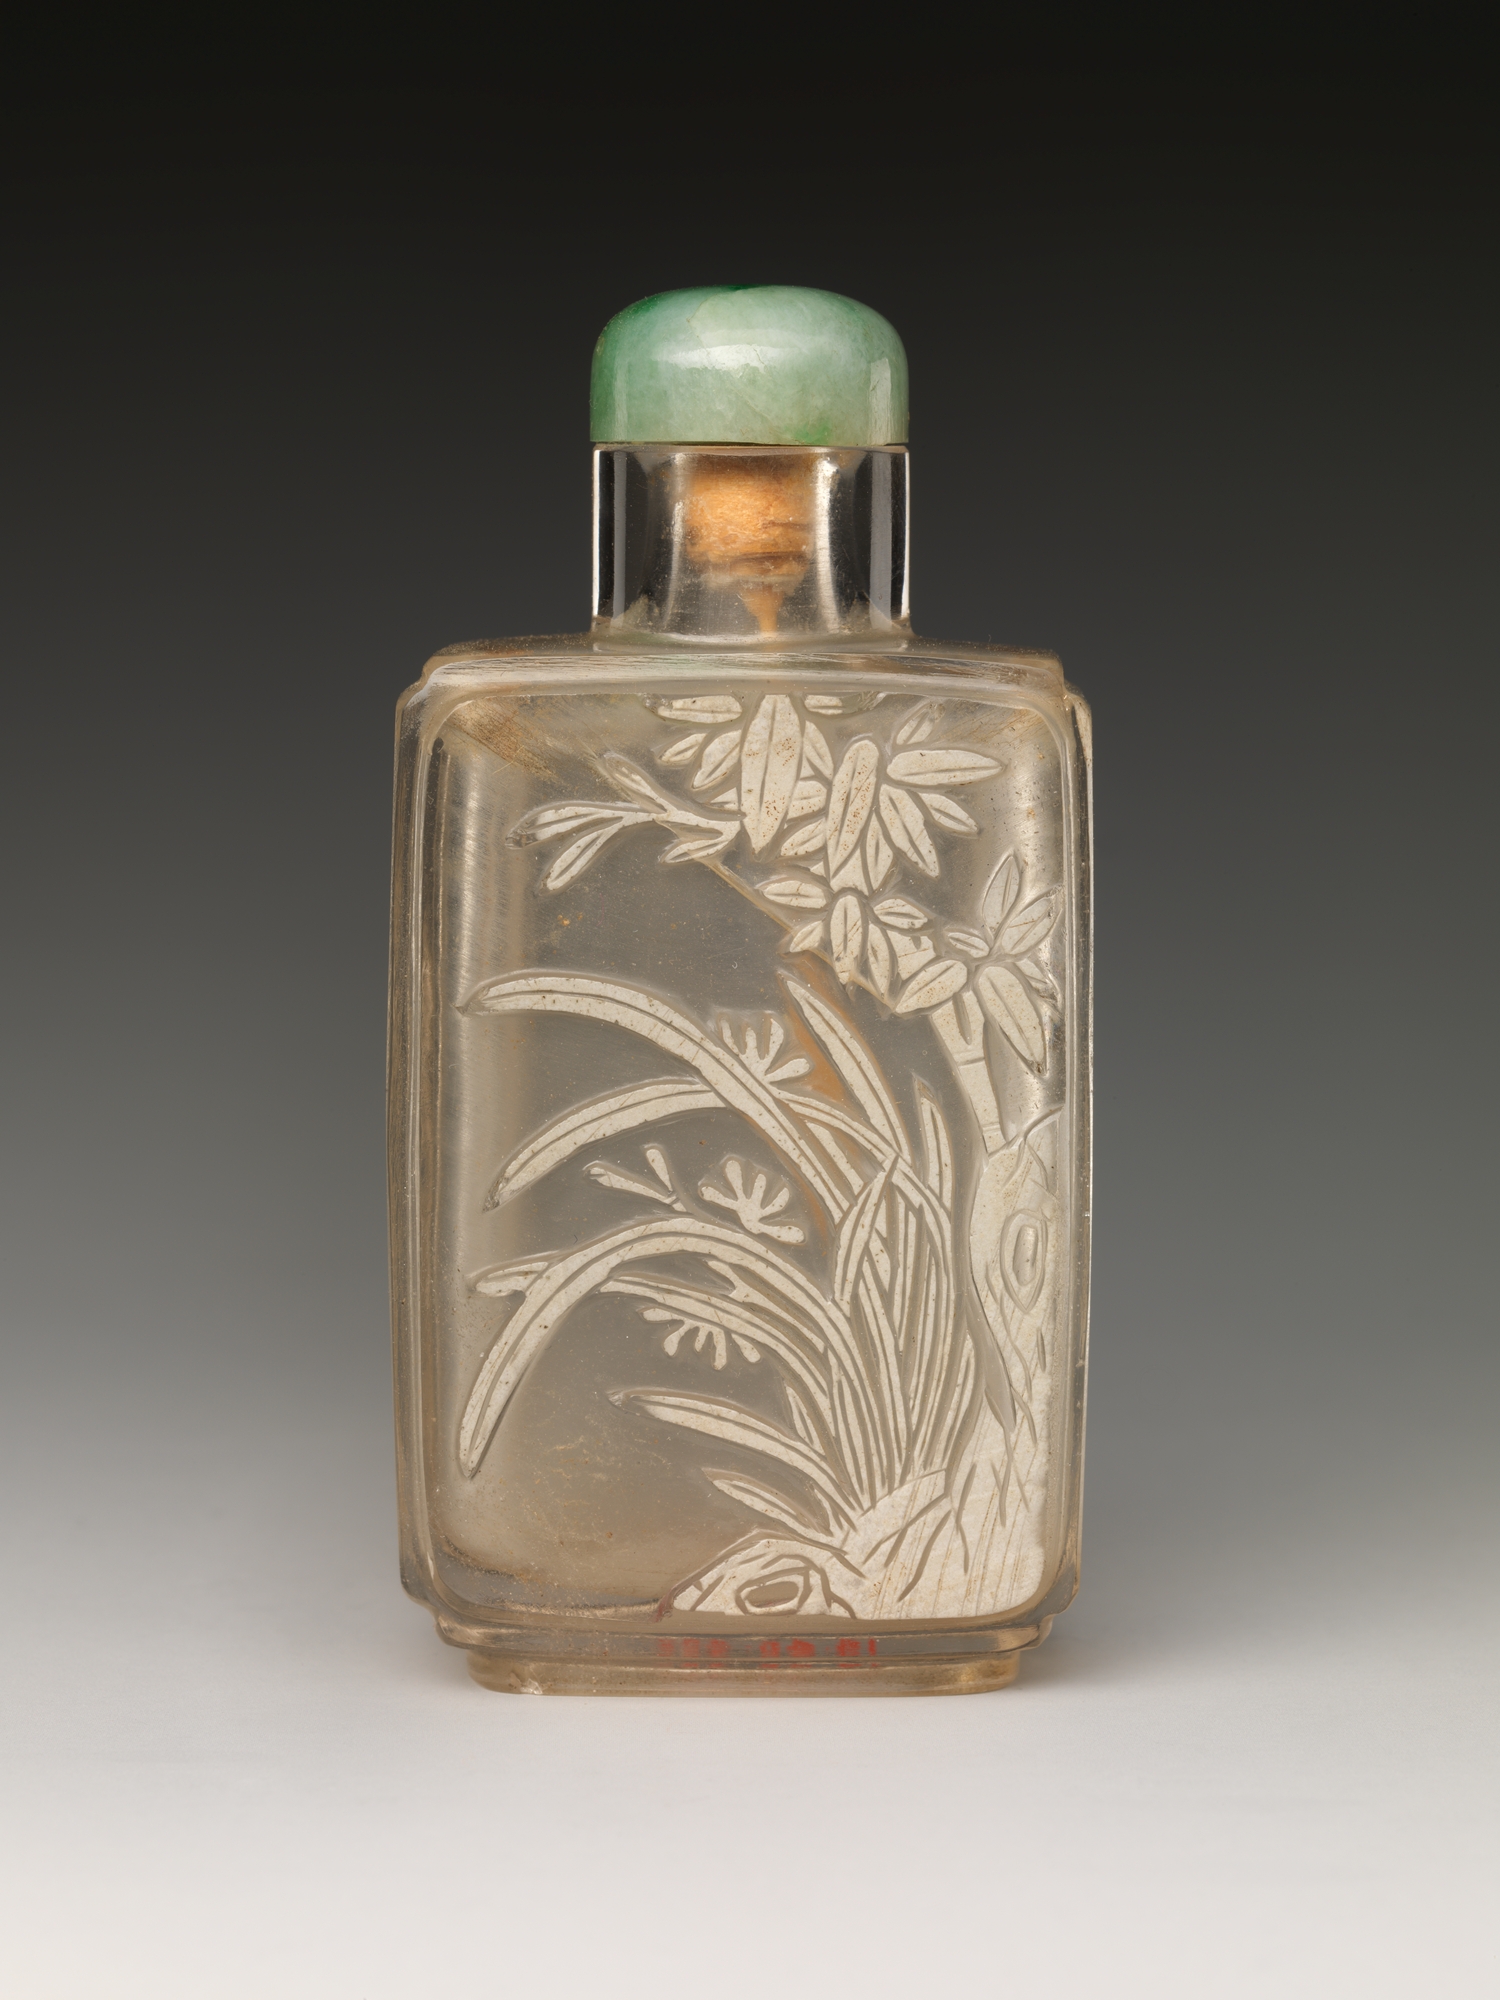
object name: snuff bottle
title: Snuff Bottle with Orchids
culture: chinese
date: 1767-1833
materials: jade, quartz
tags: orchids